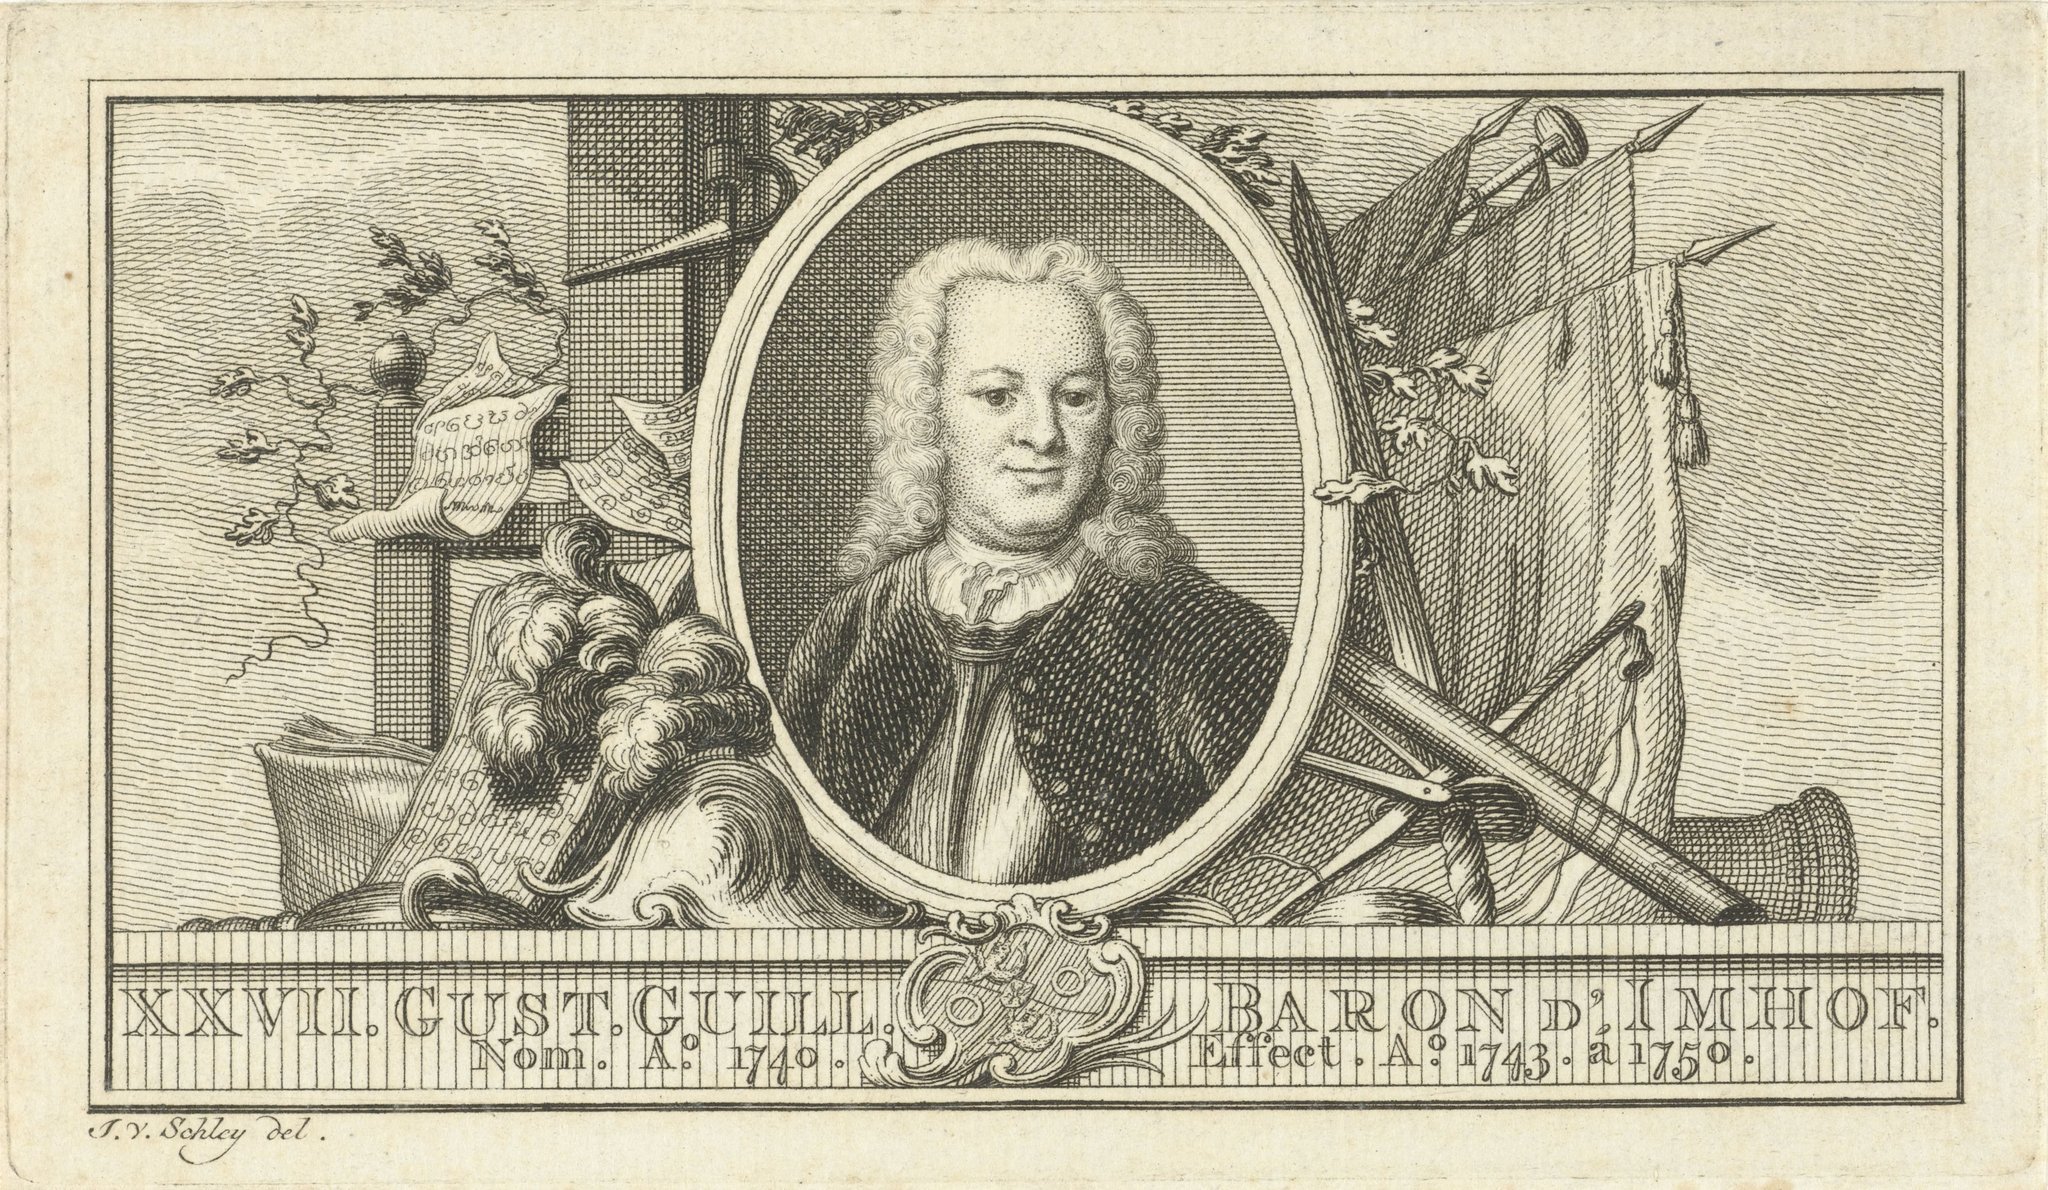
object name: print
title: Portret van Gustaaf Willem Baron van Imhoff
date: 1763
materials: paper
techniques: engraving, etching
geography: amsterdam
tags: leer (duitsland), gouverneur-generaal, gustaaf willem baron van imhoff (1705-1750)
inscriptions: collector's mark: Lugt 964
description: Ook gebruikt als llustratie in: Du Bois, J.P.I. Vies des gouverneurs généraux avec l'abrégé de l'histoire des établissemens hollandais aux Indes Orientales. Den Haag: Pierre de Hondt, 1763, p. 336.